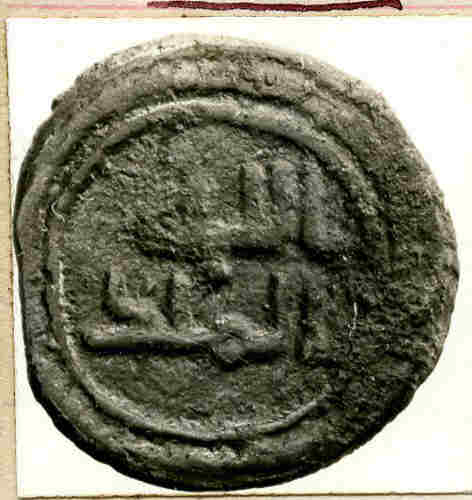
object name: coin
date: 701-800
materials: copper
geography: iran